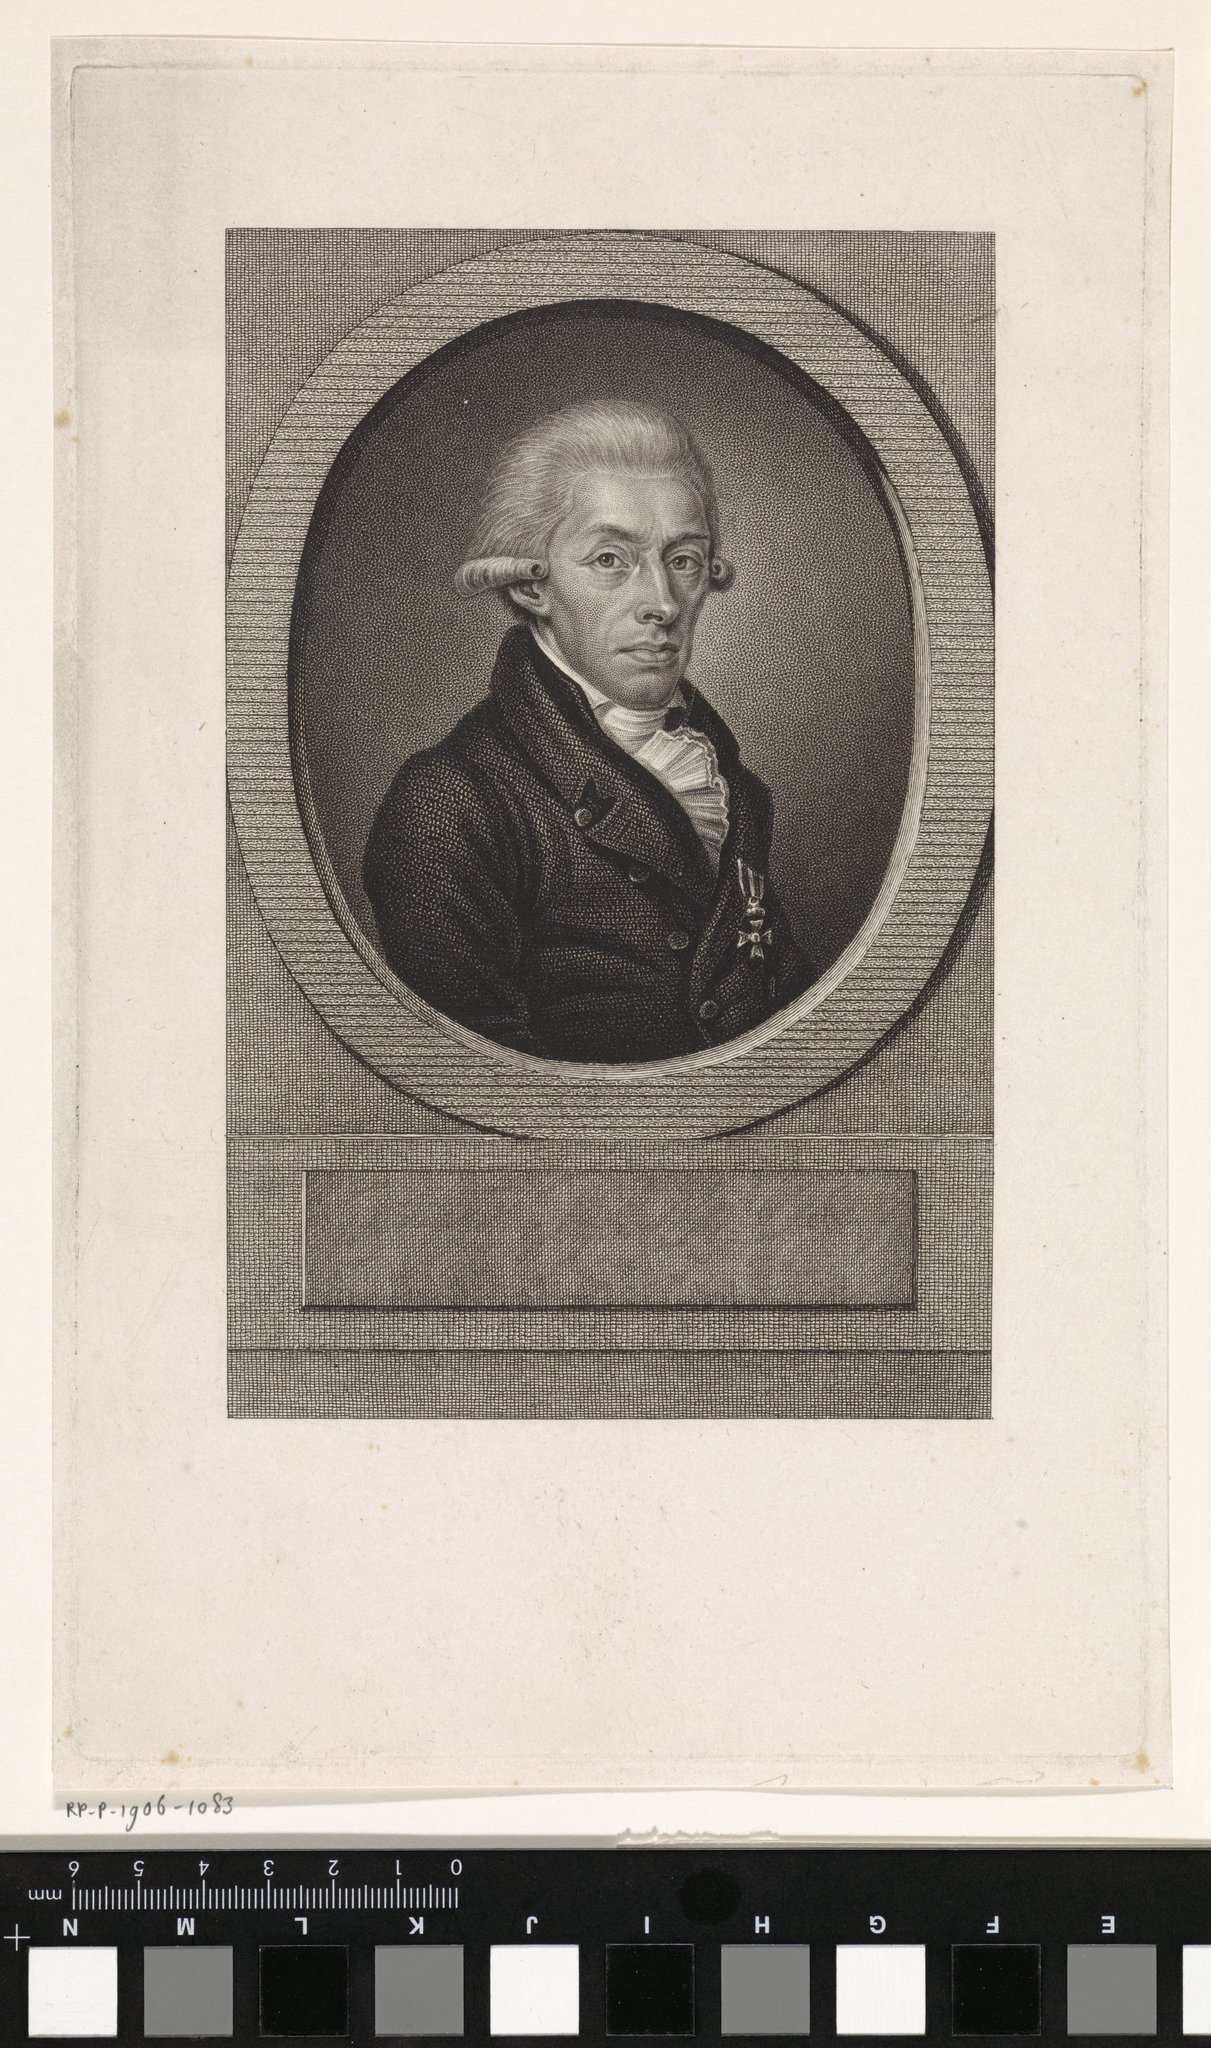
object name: print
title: Portret van Rhijnvis Feith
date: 1783-1851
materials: paper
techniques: engraving, etching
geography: netherlands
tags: rhijnvis feith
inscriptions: collector's mark: Lugt 2228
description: Portret van de letterkundige, schrijver en dichter Rhijnvis Feith.